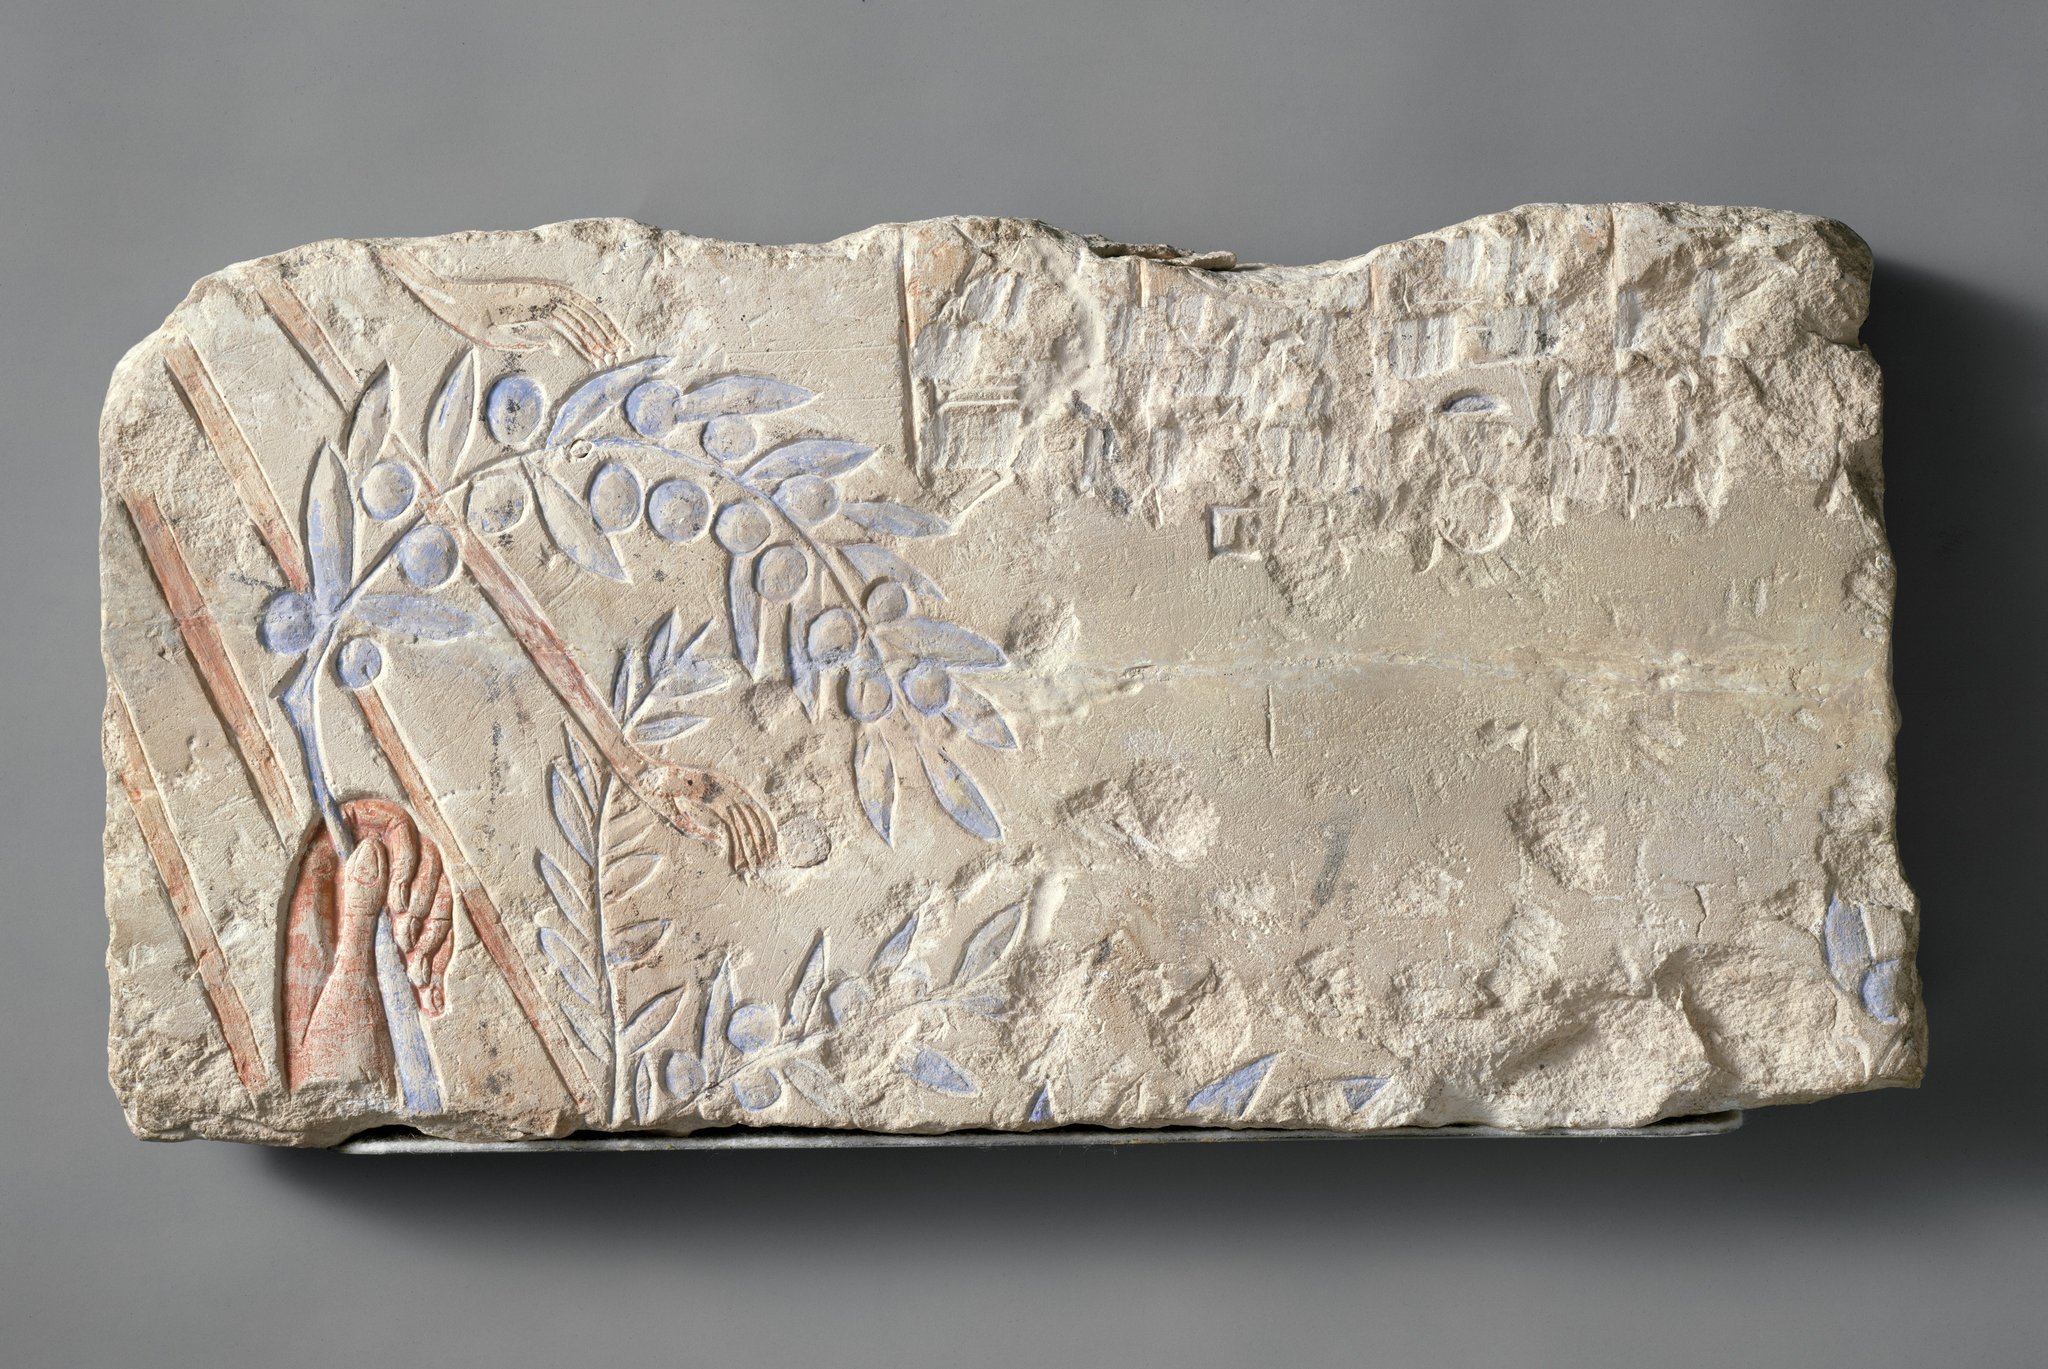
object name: talatat, olive branch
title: Hand Clutching an Olive Branch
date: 1353-1323 BCE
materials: limestone, paint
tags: hands,olive trees